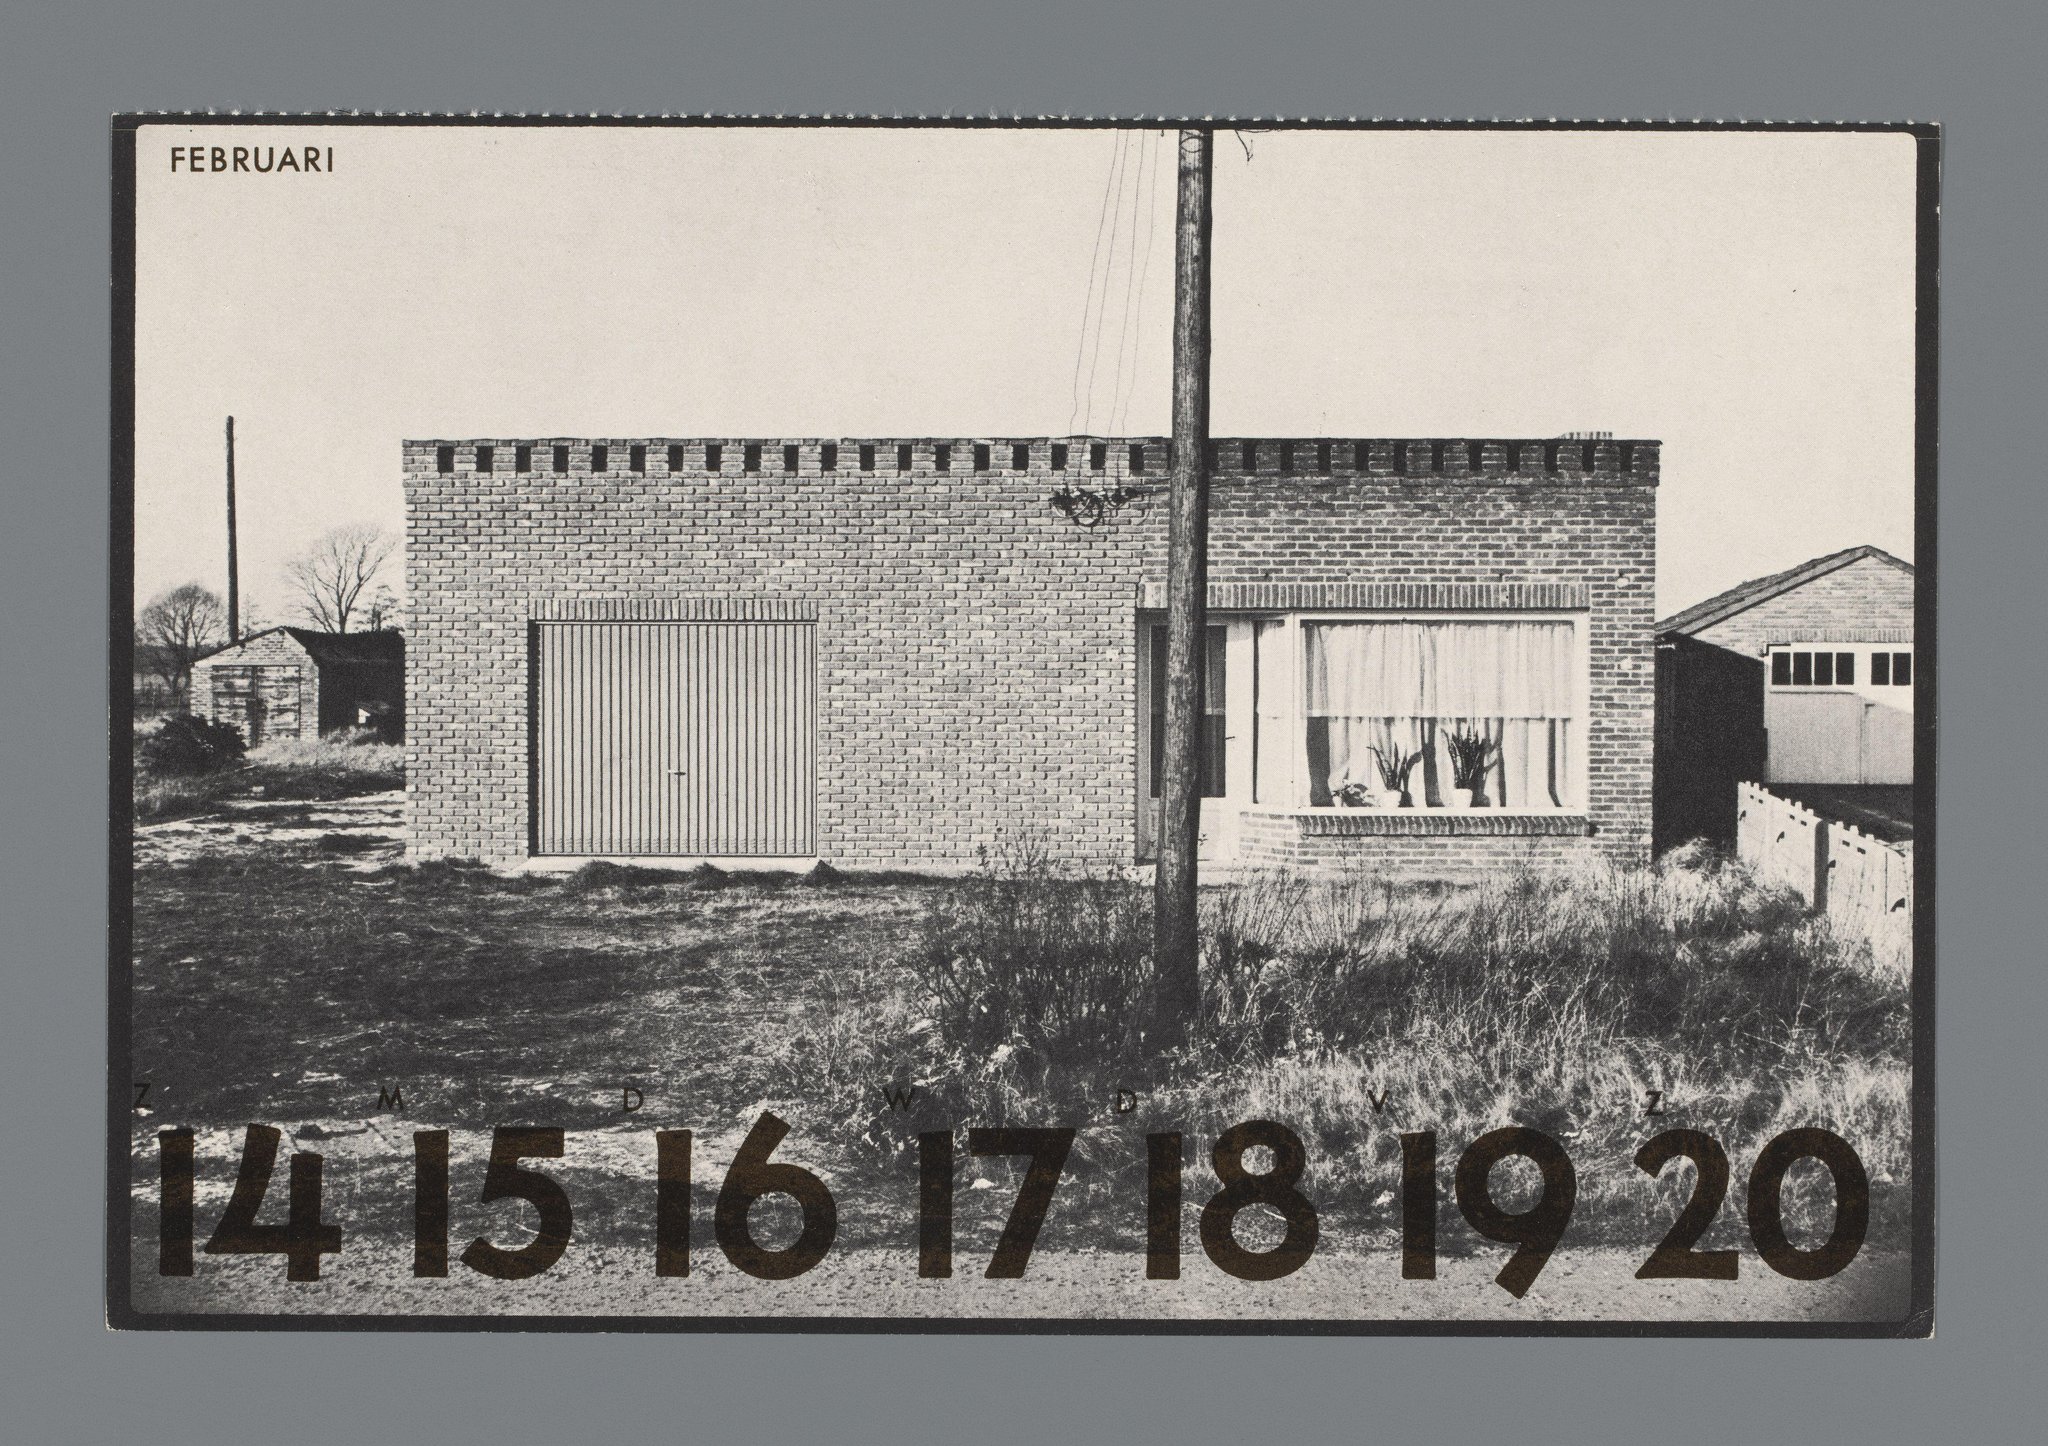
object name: photograph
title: België. Huizen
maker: Anonymous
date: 1900-1950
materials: paper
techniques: offset printed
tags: belgium